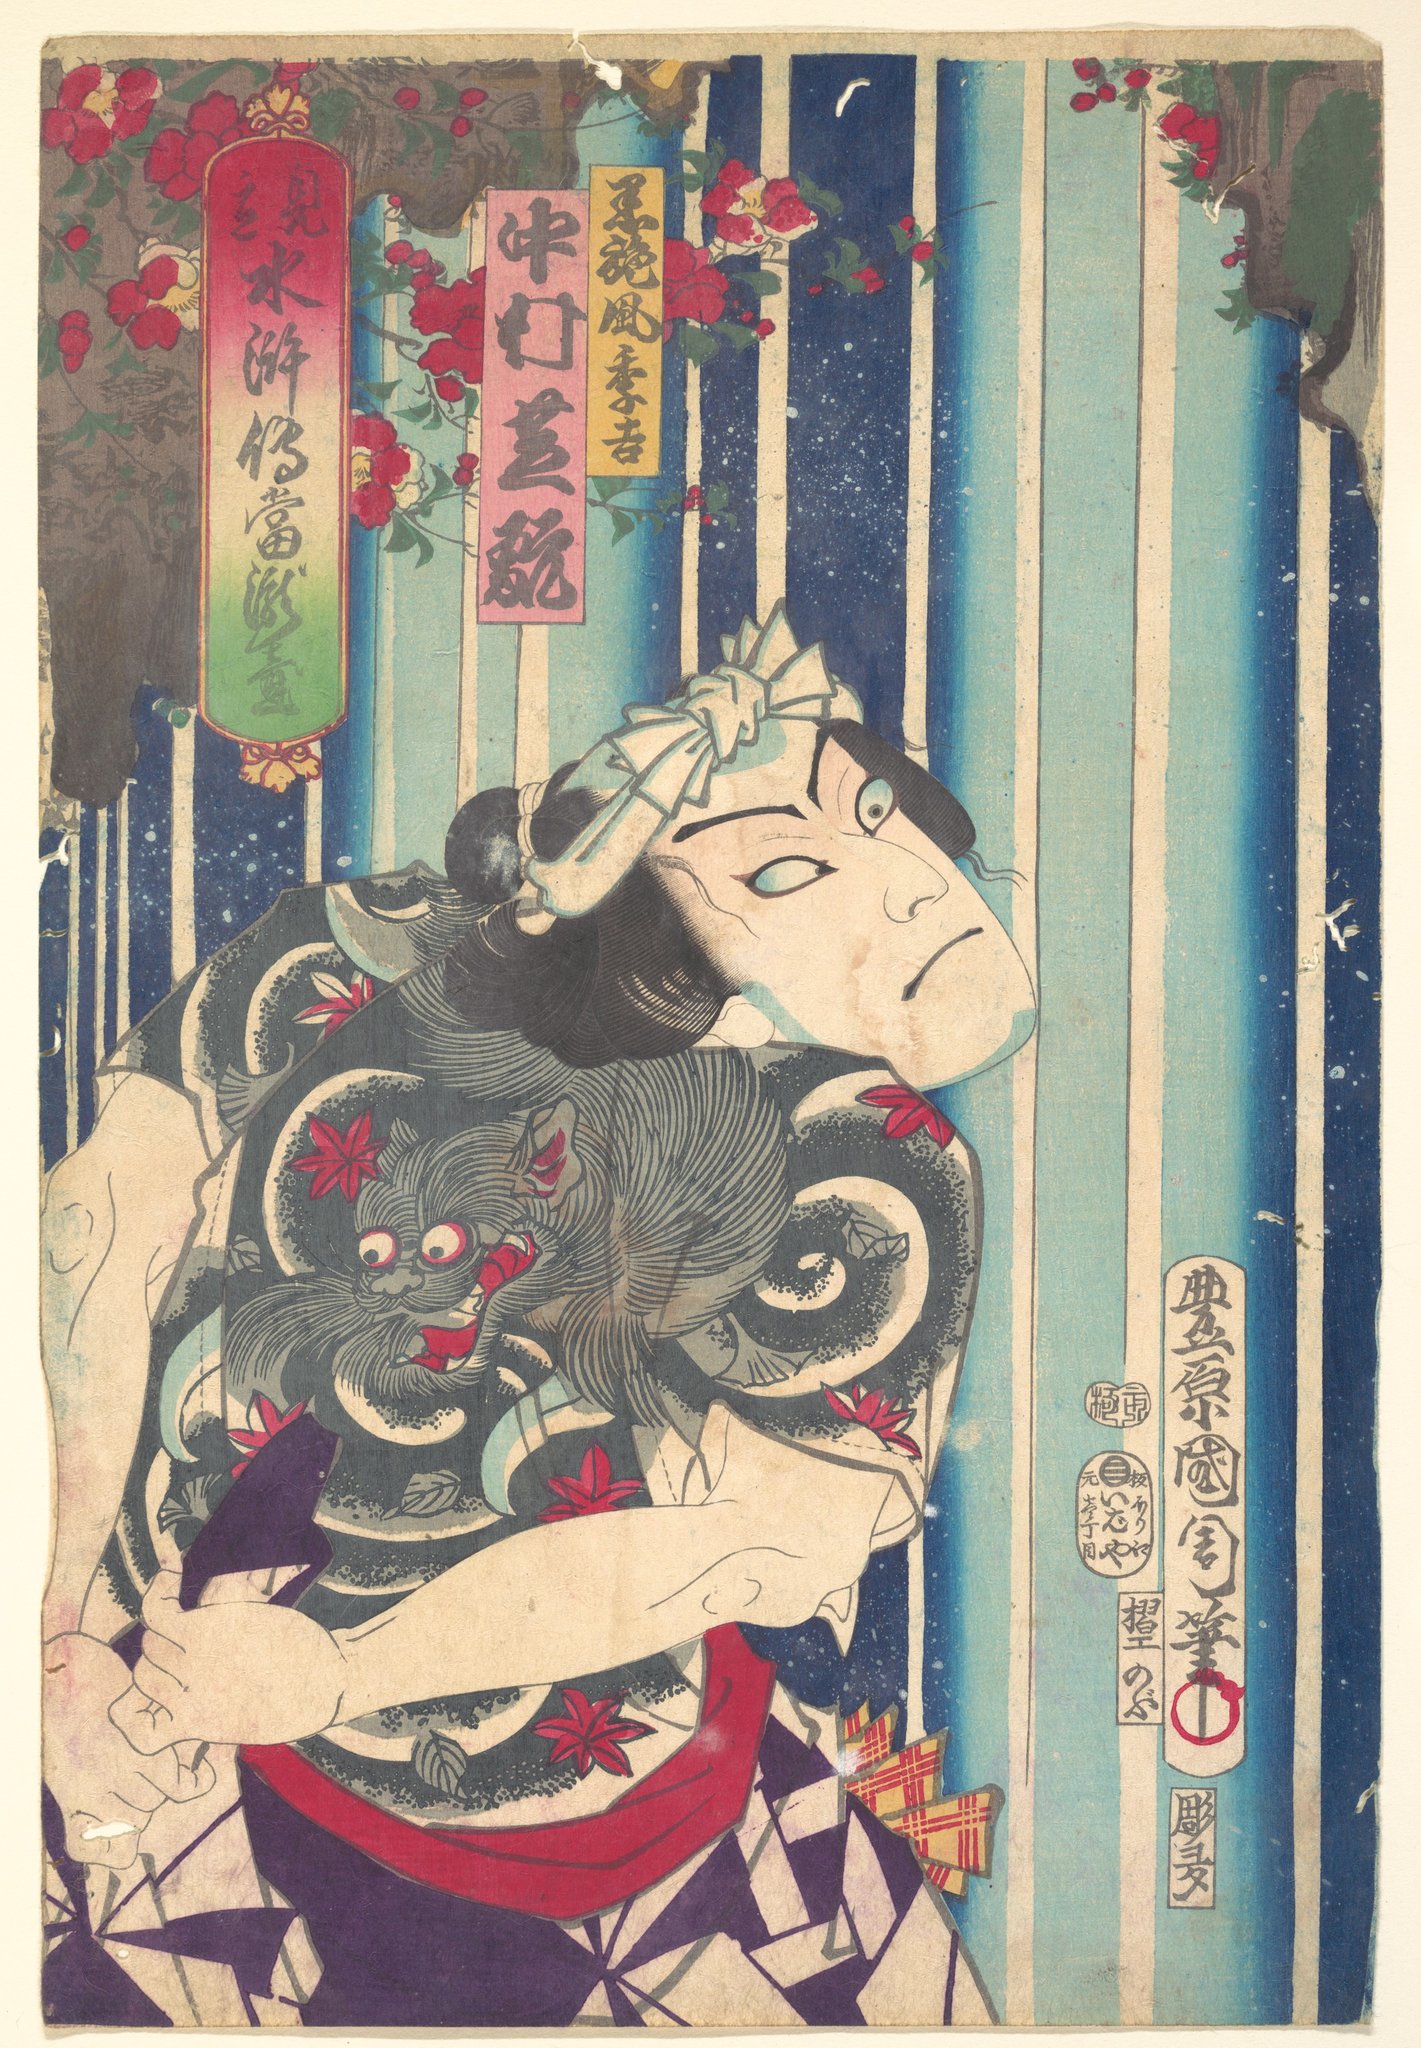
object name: print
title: Imaginary portrait, Shuihuzhuan of Stage: Tōryūdai (Mitate Suikoden Tōrōdai) - Actor Nakamura Shikan plays Suekichi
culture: japanese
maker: toyohara kunichika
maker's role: artist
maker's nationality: japanese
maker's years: 1835-1900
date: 1875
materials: ink, paper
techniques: woodblock print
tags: animals,men,actors